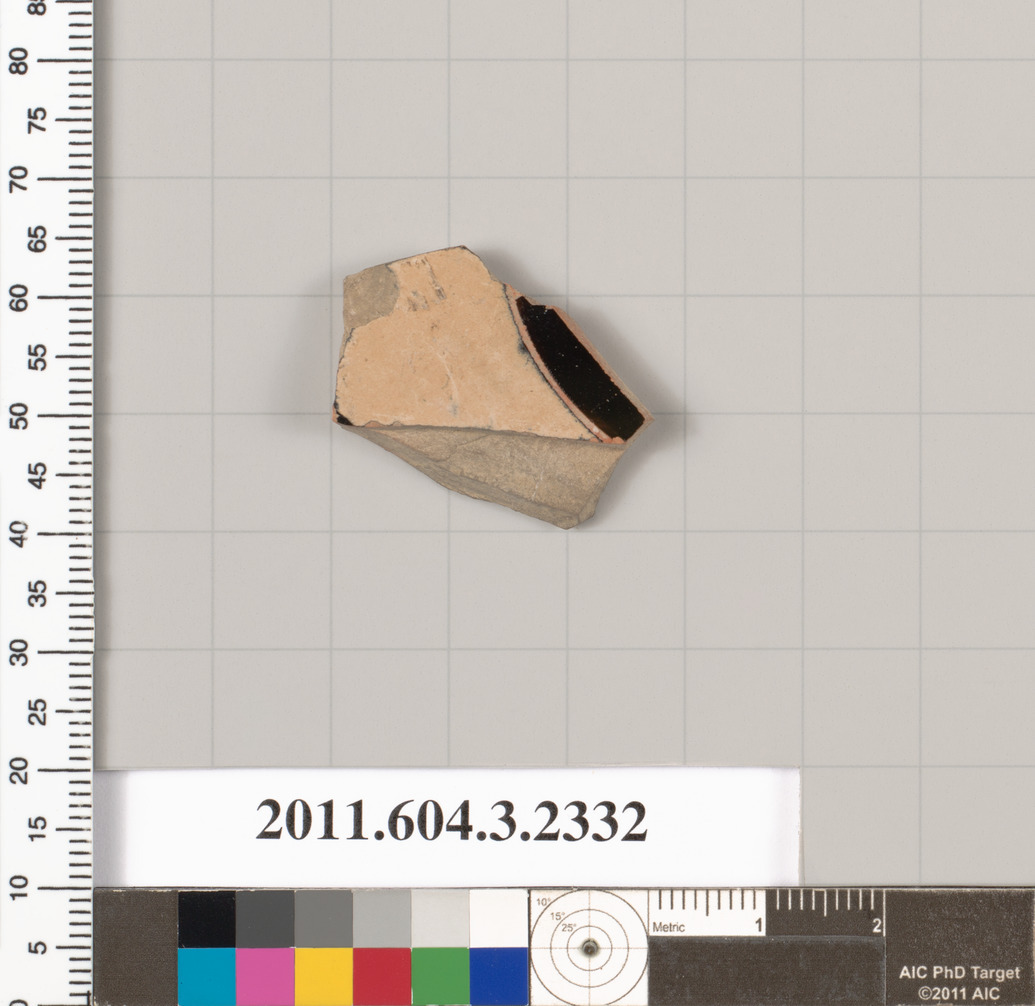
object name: kylix fragment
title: Terracotta fragment of a kylix: eye-cup (drinking cup)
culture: greek, attic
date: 540-520 BCE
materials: terracotta